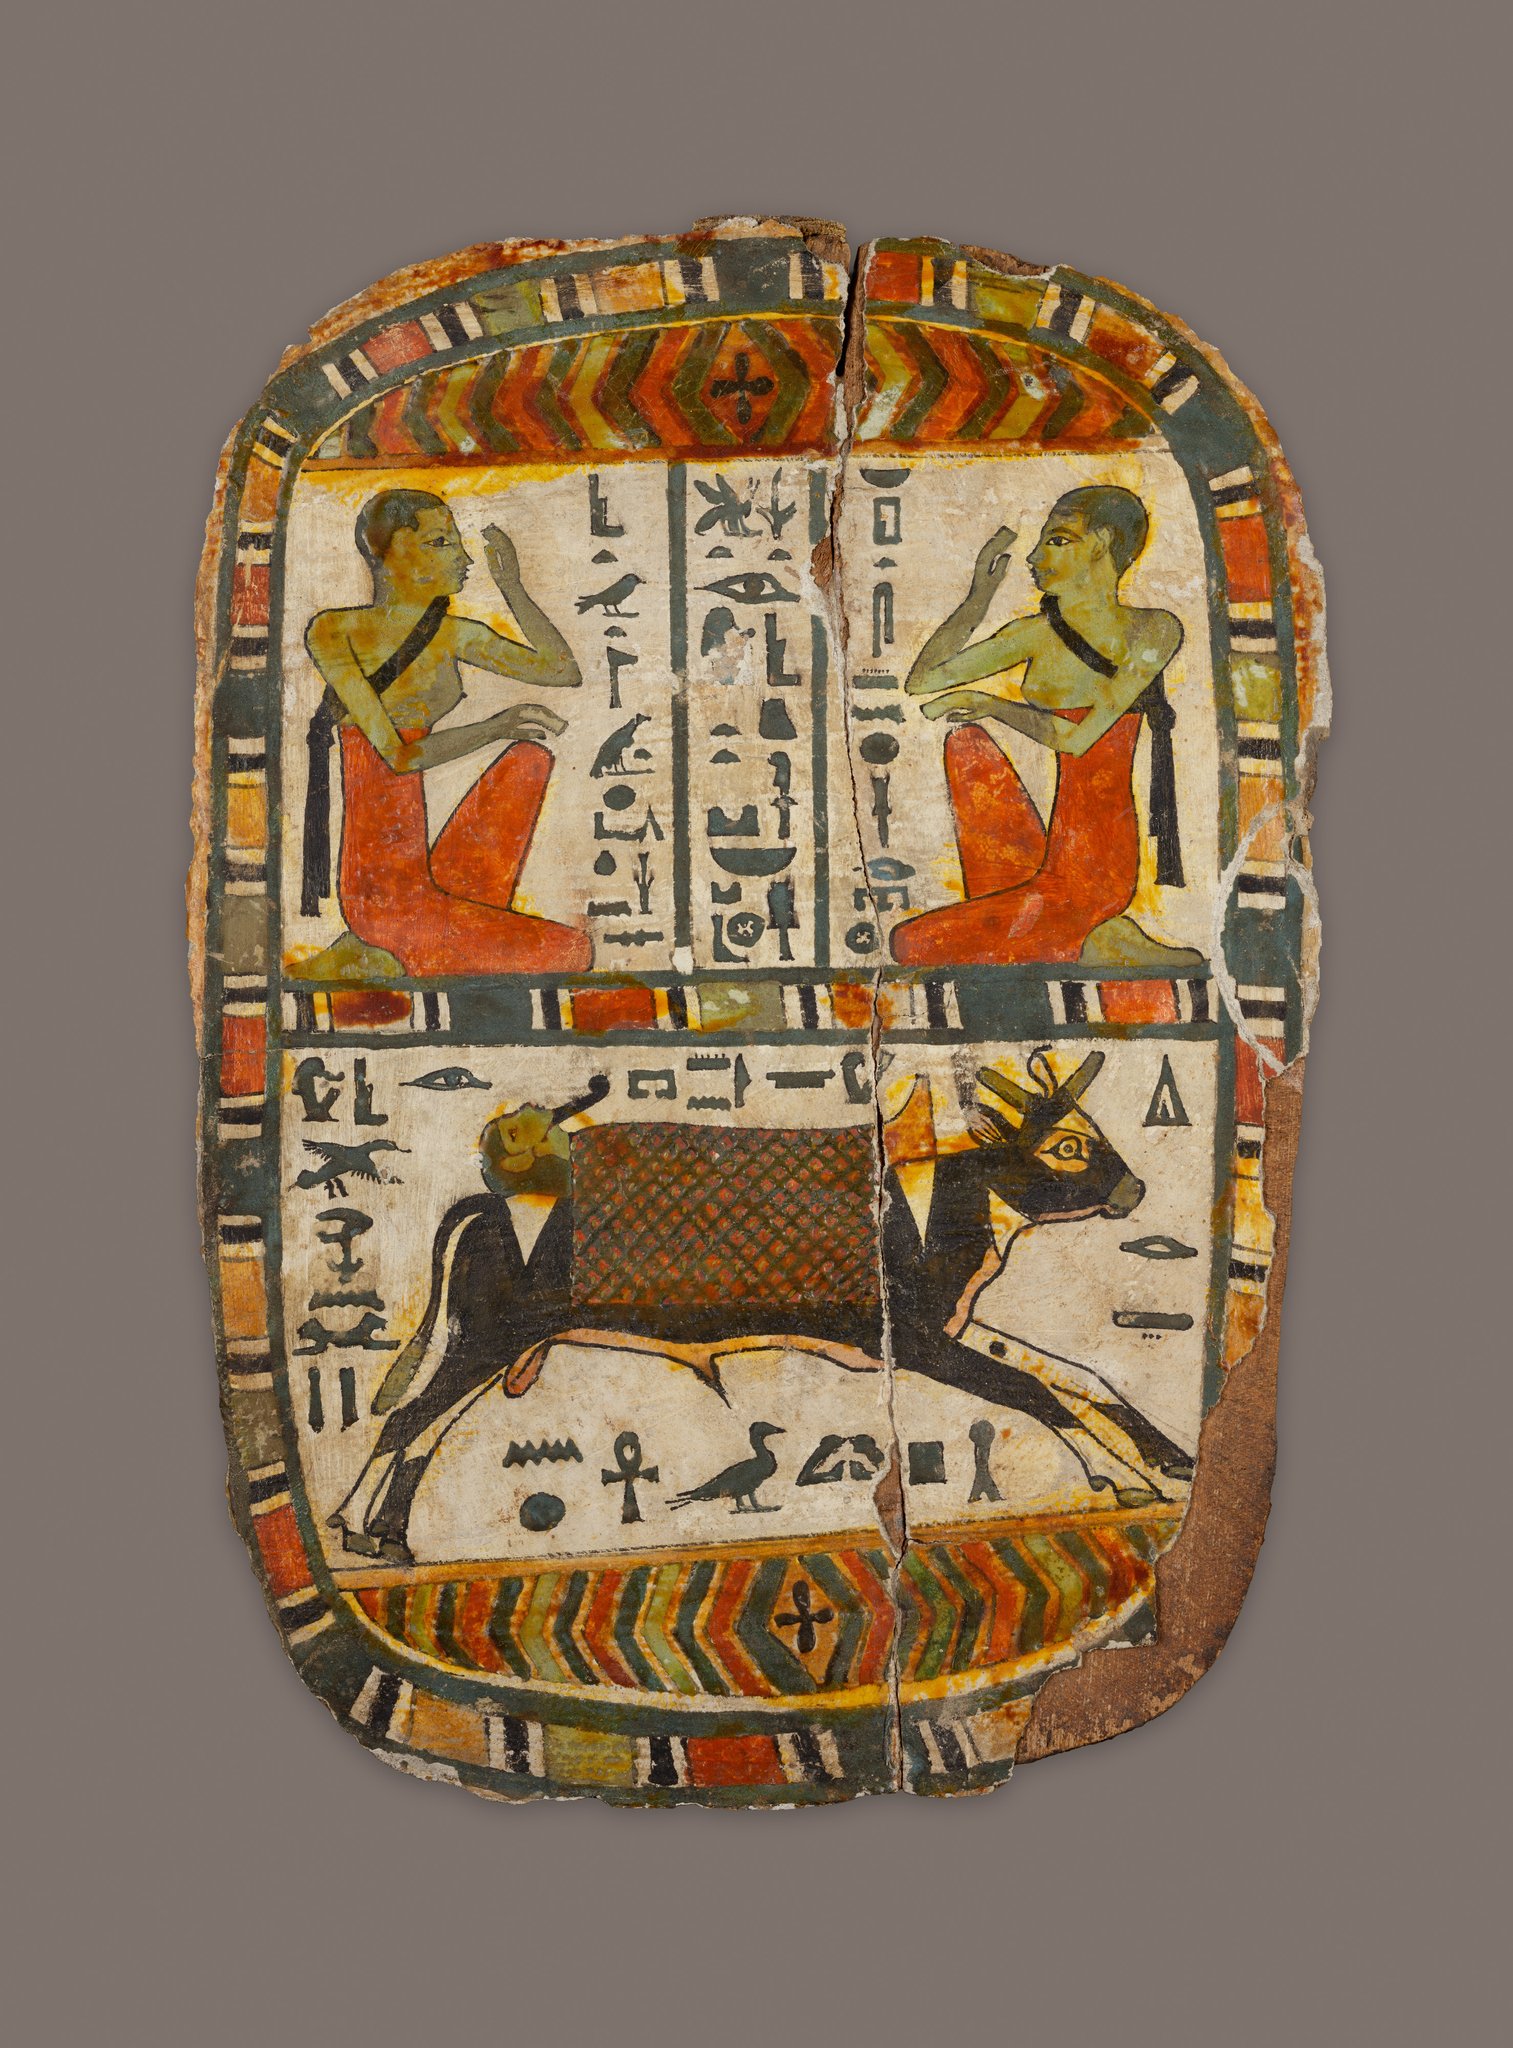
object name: coffin foot, pakherenkhonsu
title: Footboard of Pakherenkhonsu's Cartonnage Case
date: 750-700 BCE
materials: paint, paste, wood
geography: egypt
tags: bulls